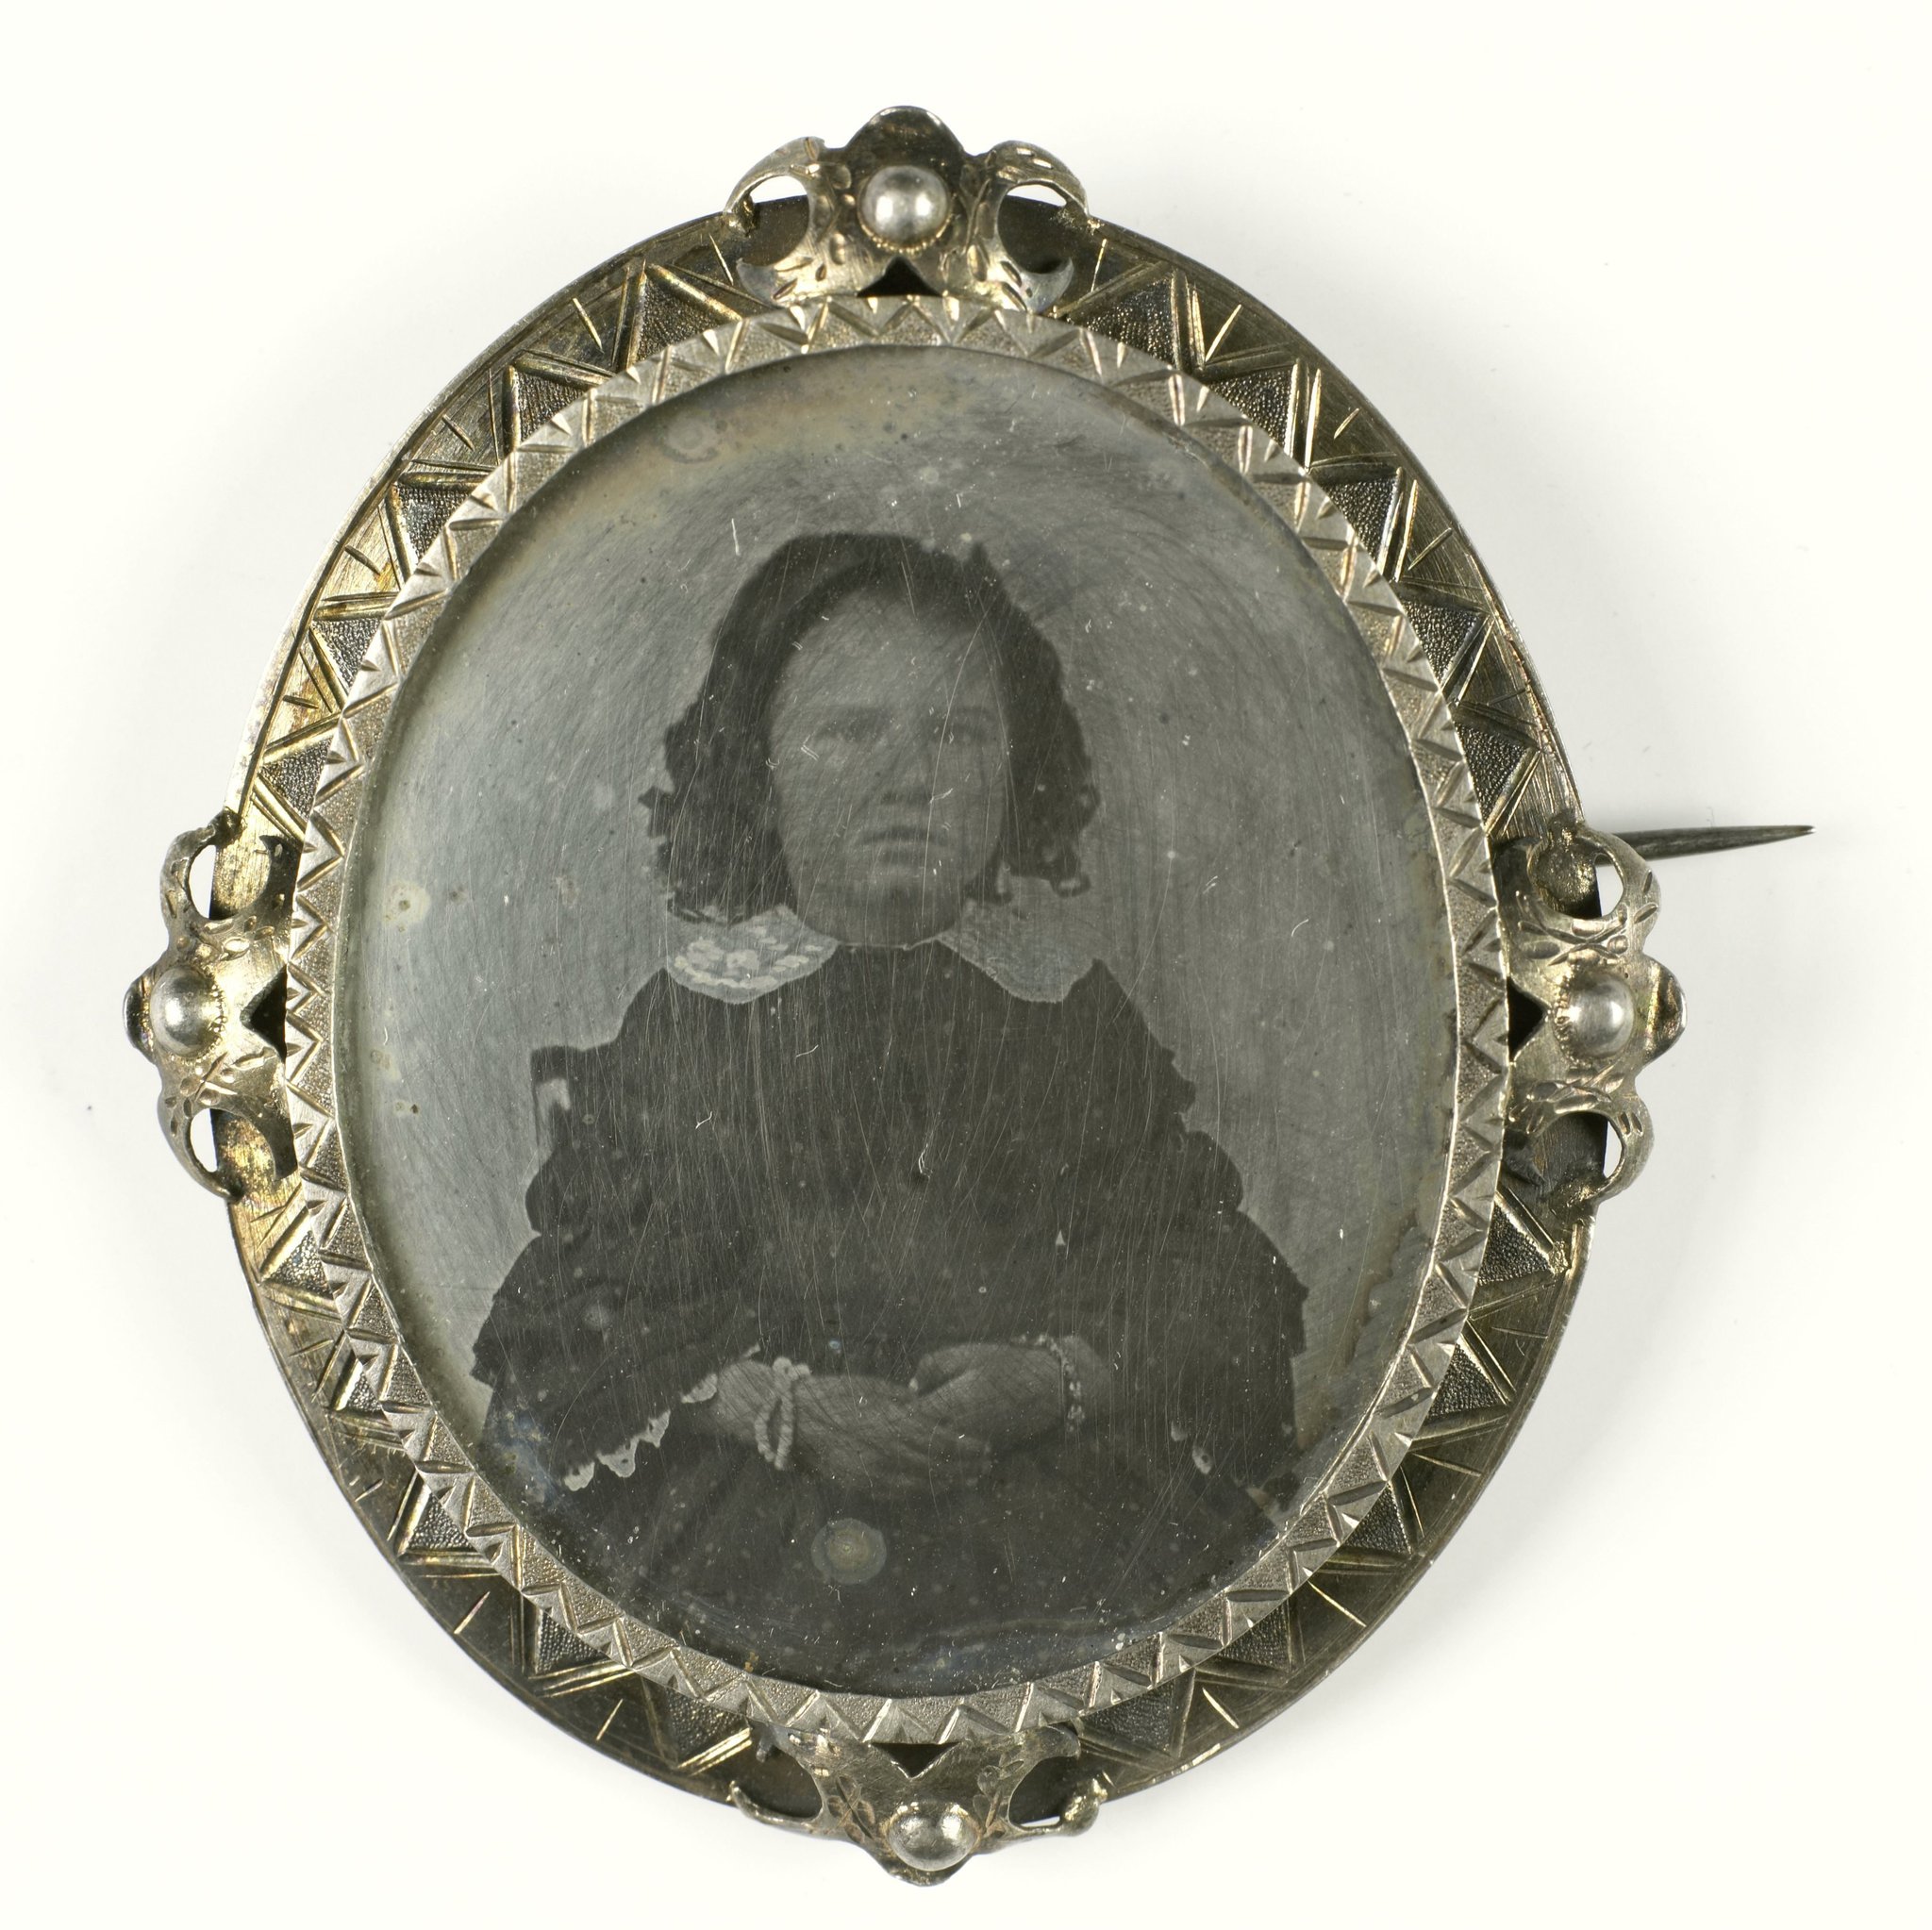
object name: photograph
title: Portret van een onbekend meisje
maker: Anonymous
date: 1840-1860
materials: copper, glass, metal, mother of pearl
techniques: daguerreotype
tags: historical persons, girl (child between toddler and youth)